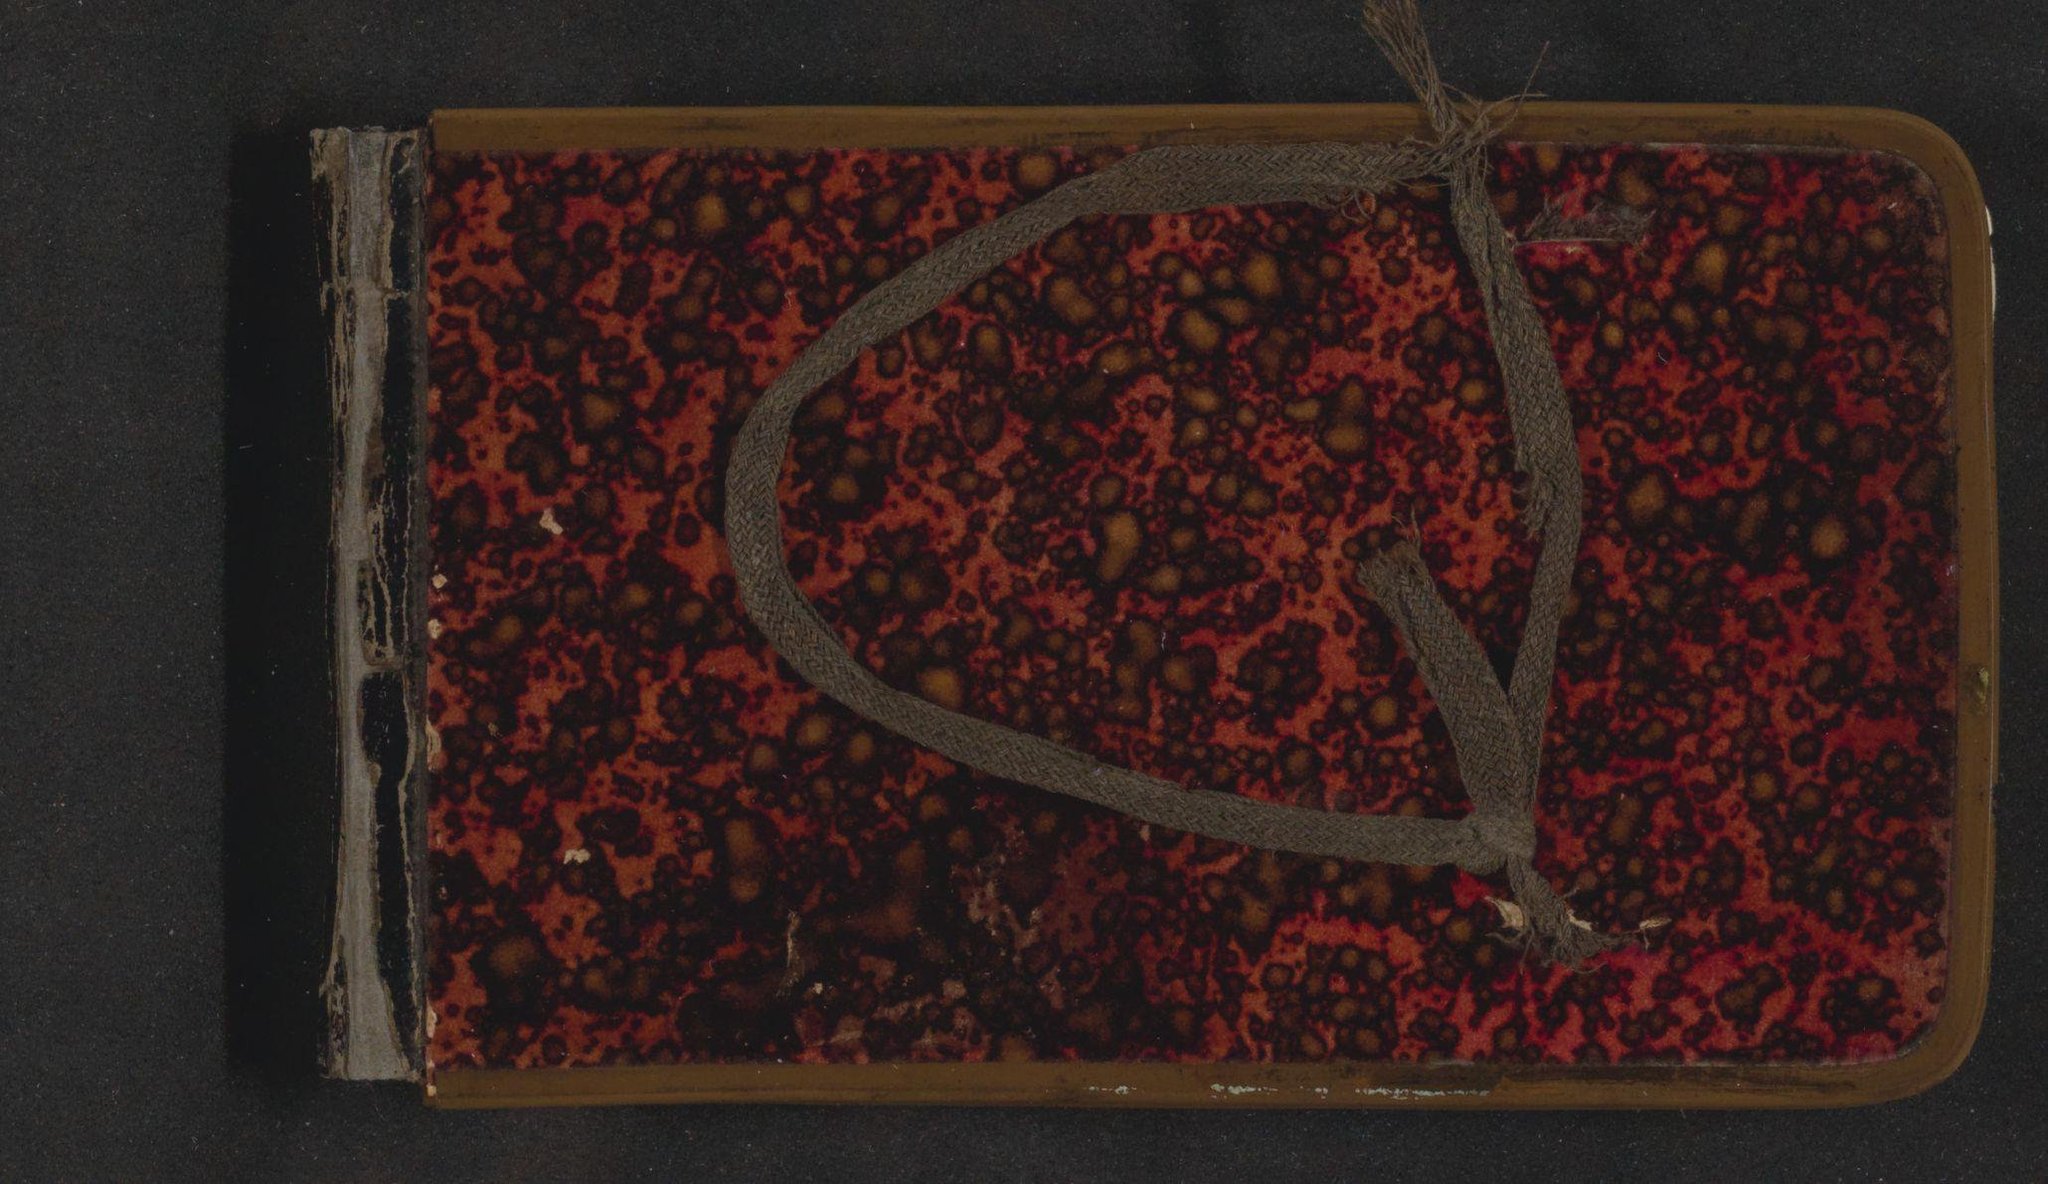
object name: sketchbook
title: Schetsboek met 69 bladen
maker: geo poggenbeek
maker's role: draughtsman, painter, print maker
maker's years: 1853-1903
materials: brass, cardboard, chalk, linen, paper, pencil, watercolor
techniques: brush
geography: southern germany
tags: city-view, and landscape with man-made constructions, animals, river, forest, wood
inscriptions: signature and date: ‘G.J.H. Poggenbeek/ Amsterdam/ Juni 1876’, collector's mark: Lugt 2228a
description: Schetsboek bestaande uit 69 bladen met landschappen, stadsgezichten, dieren en figuren gemaakt tijdens een reis door Zuid-Duitsland in gezelschap van Jacob Frederik Klinkhamer beginnend te Heidelberg, door het Zwarte Woud en eindigend te Bazel.